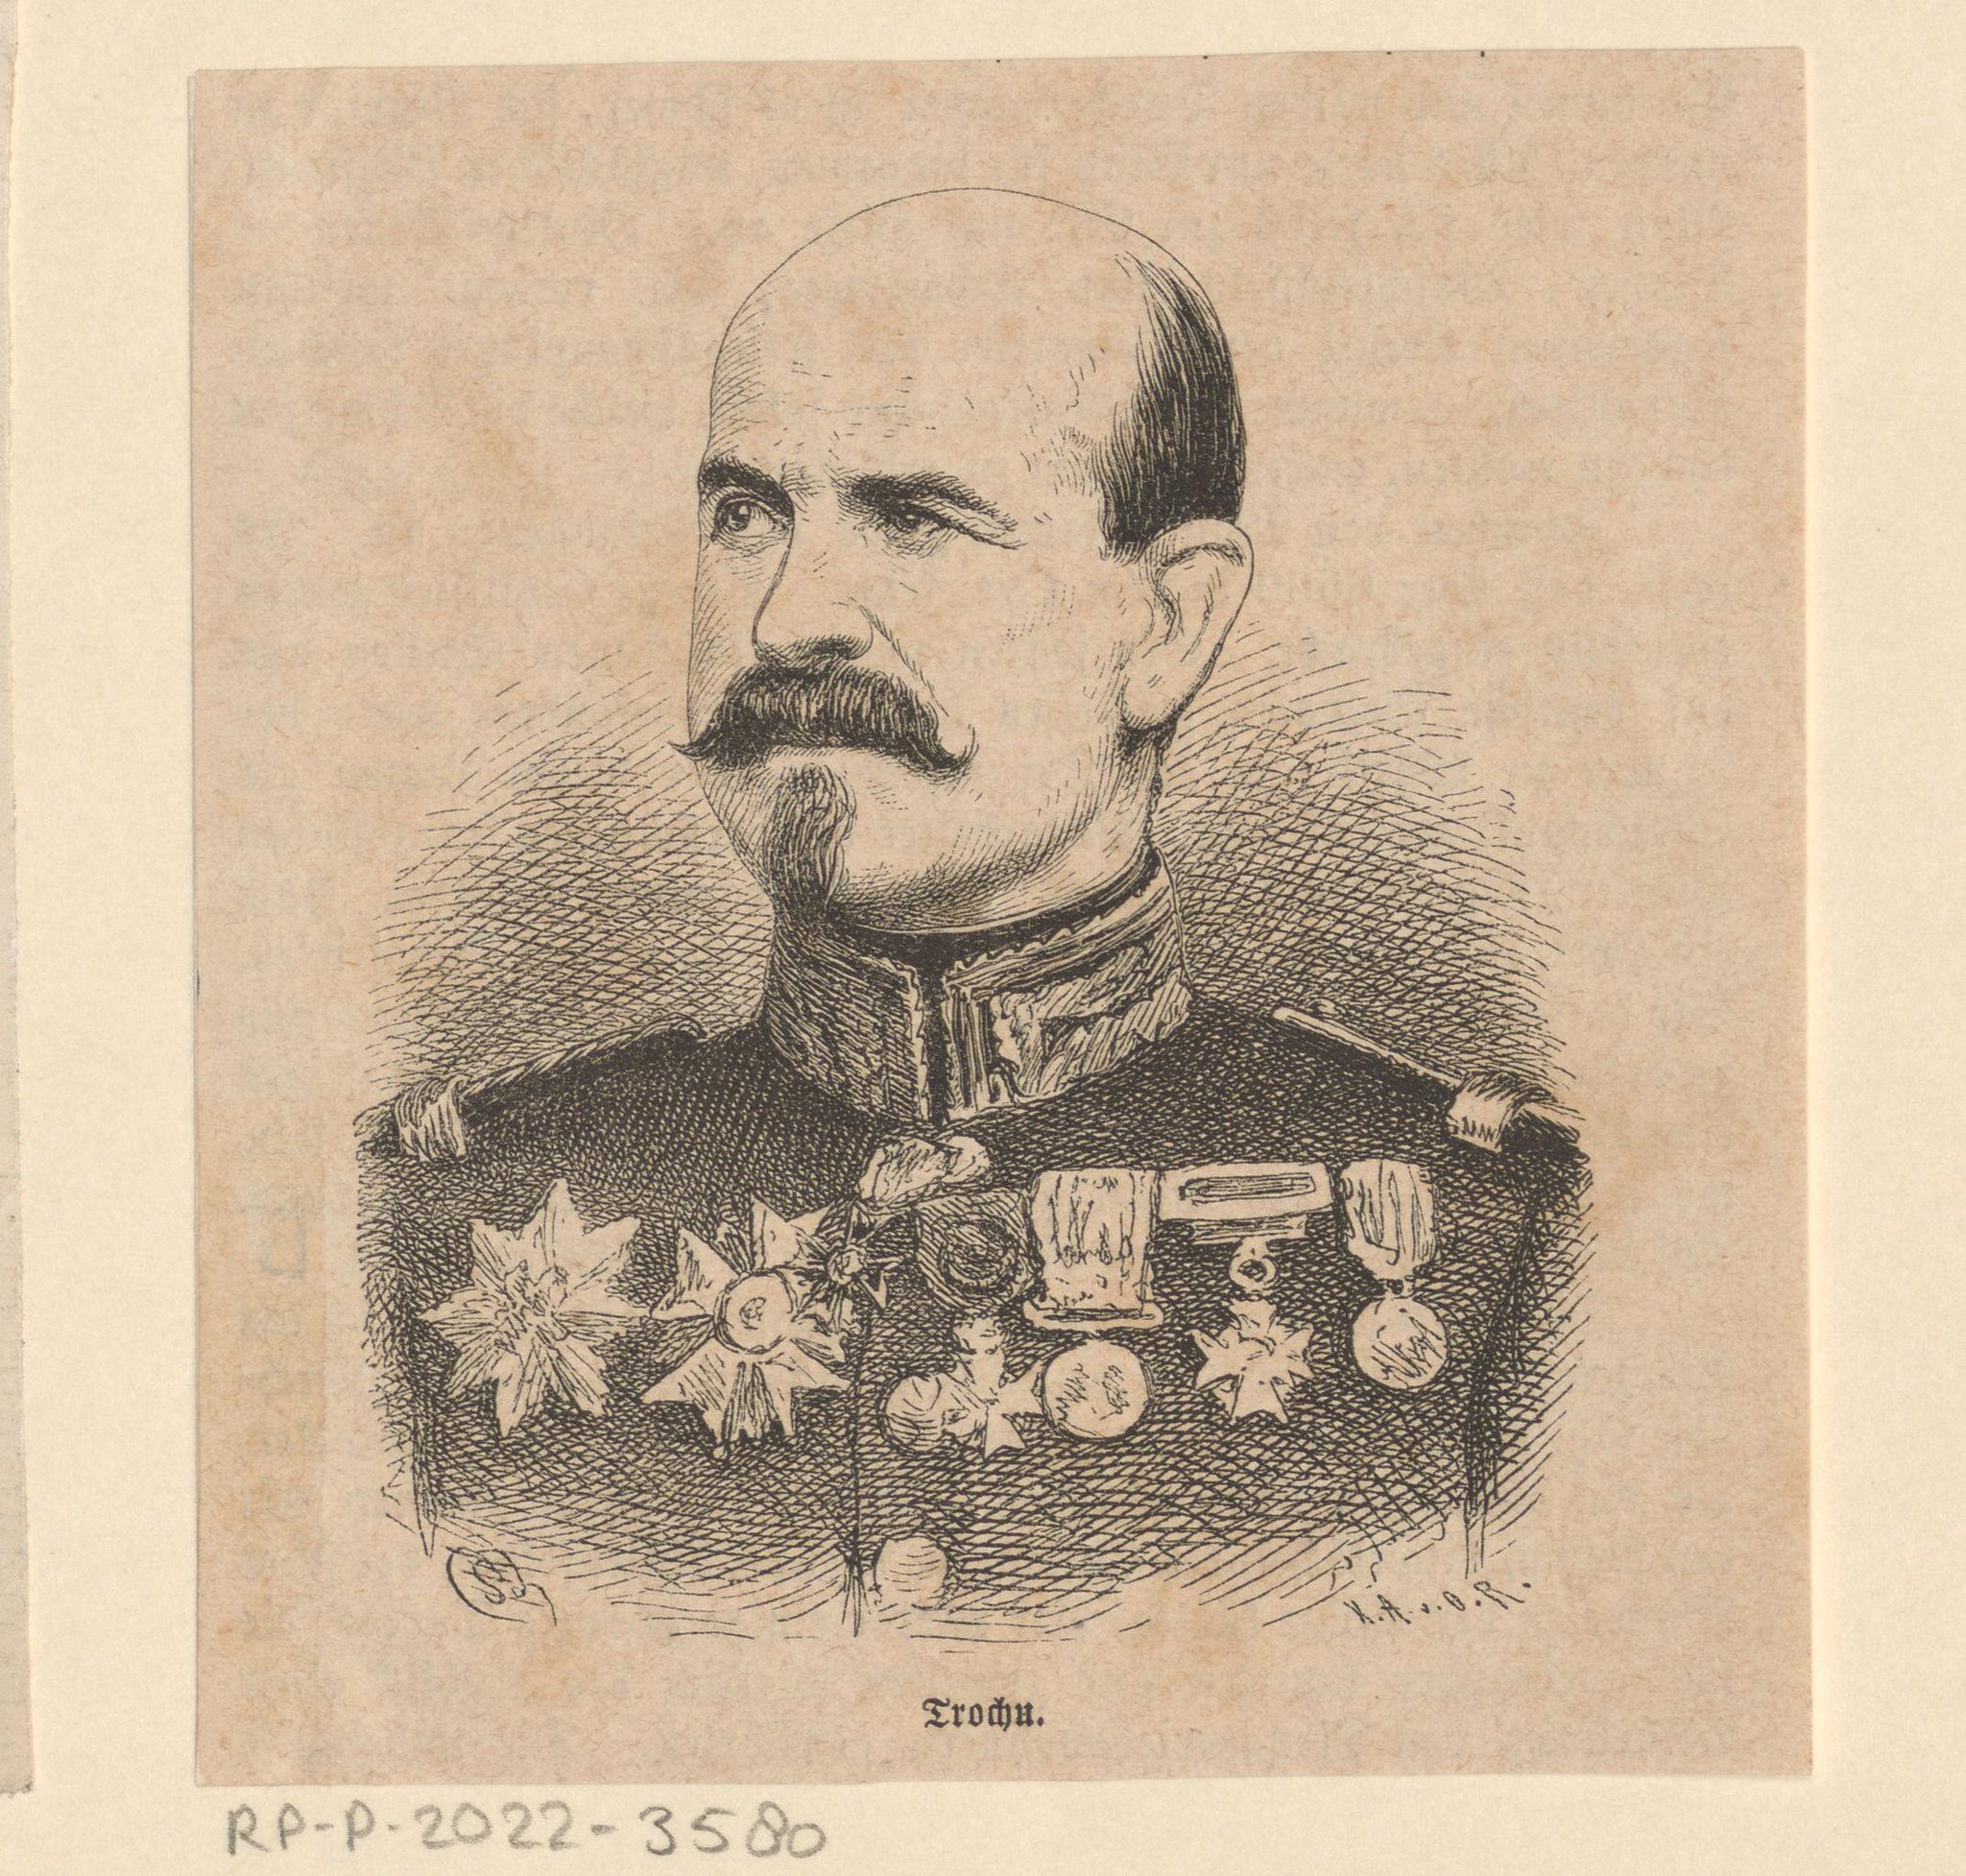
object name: print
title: Portret van Louis Jules Trochu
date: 1870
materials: paper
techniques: letterpress printing, engraving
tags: politician, commander-in-chief, general, marshal, historical persons, medals and other marks of military honour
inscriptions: monogram: ‘X.A.v.O.R.’, monogram: ‘(S)’